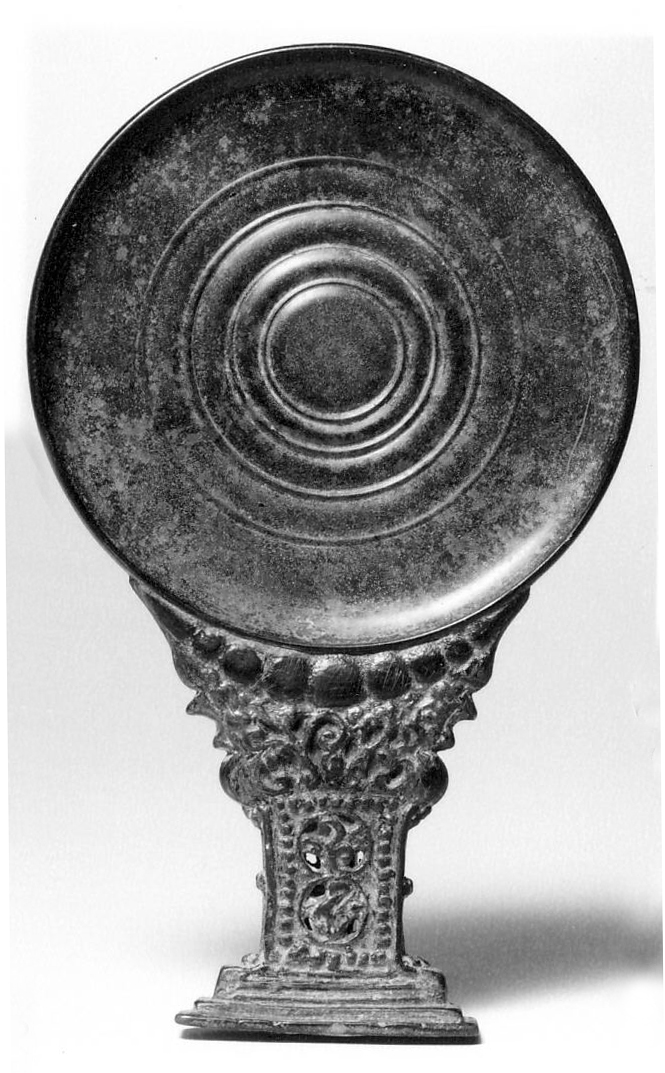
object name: mirror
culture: indonesian, javanese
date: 901-1100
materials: bronze